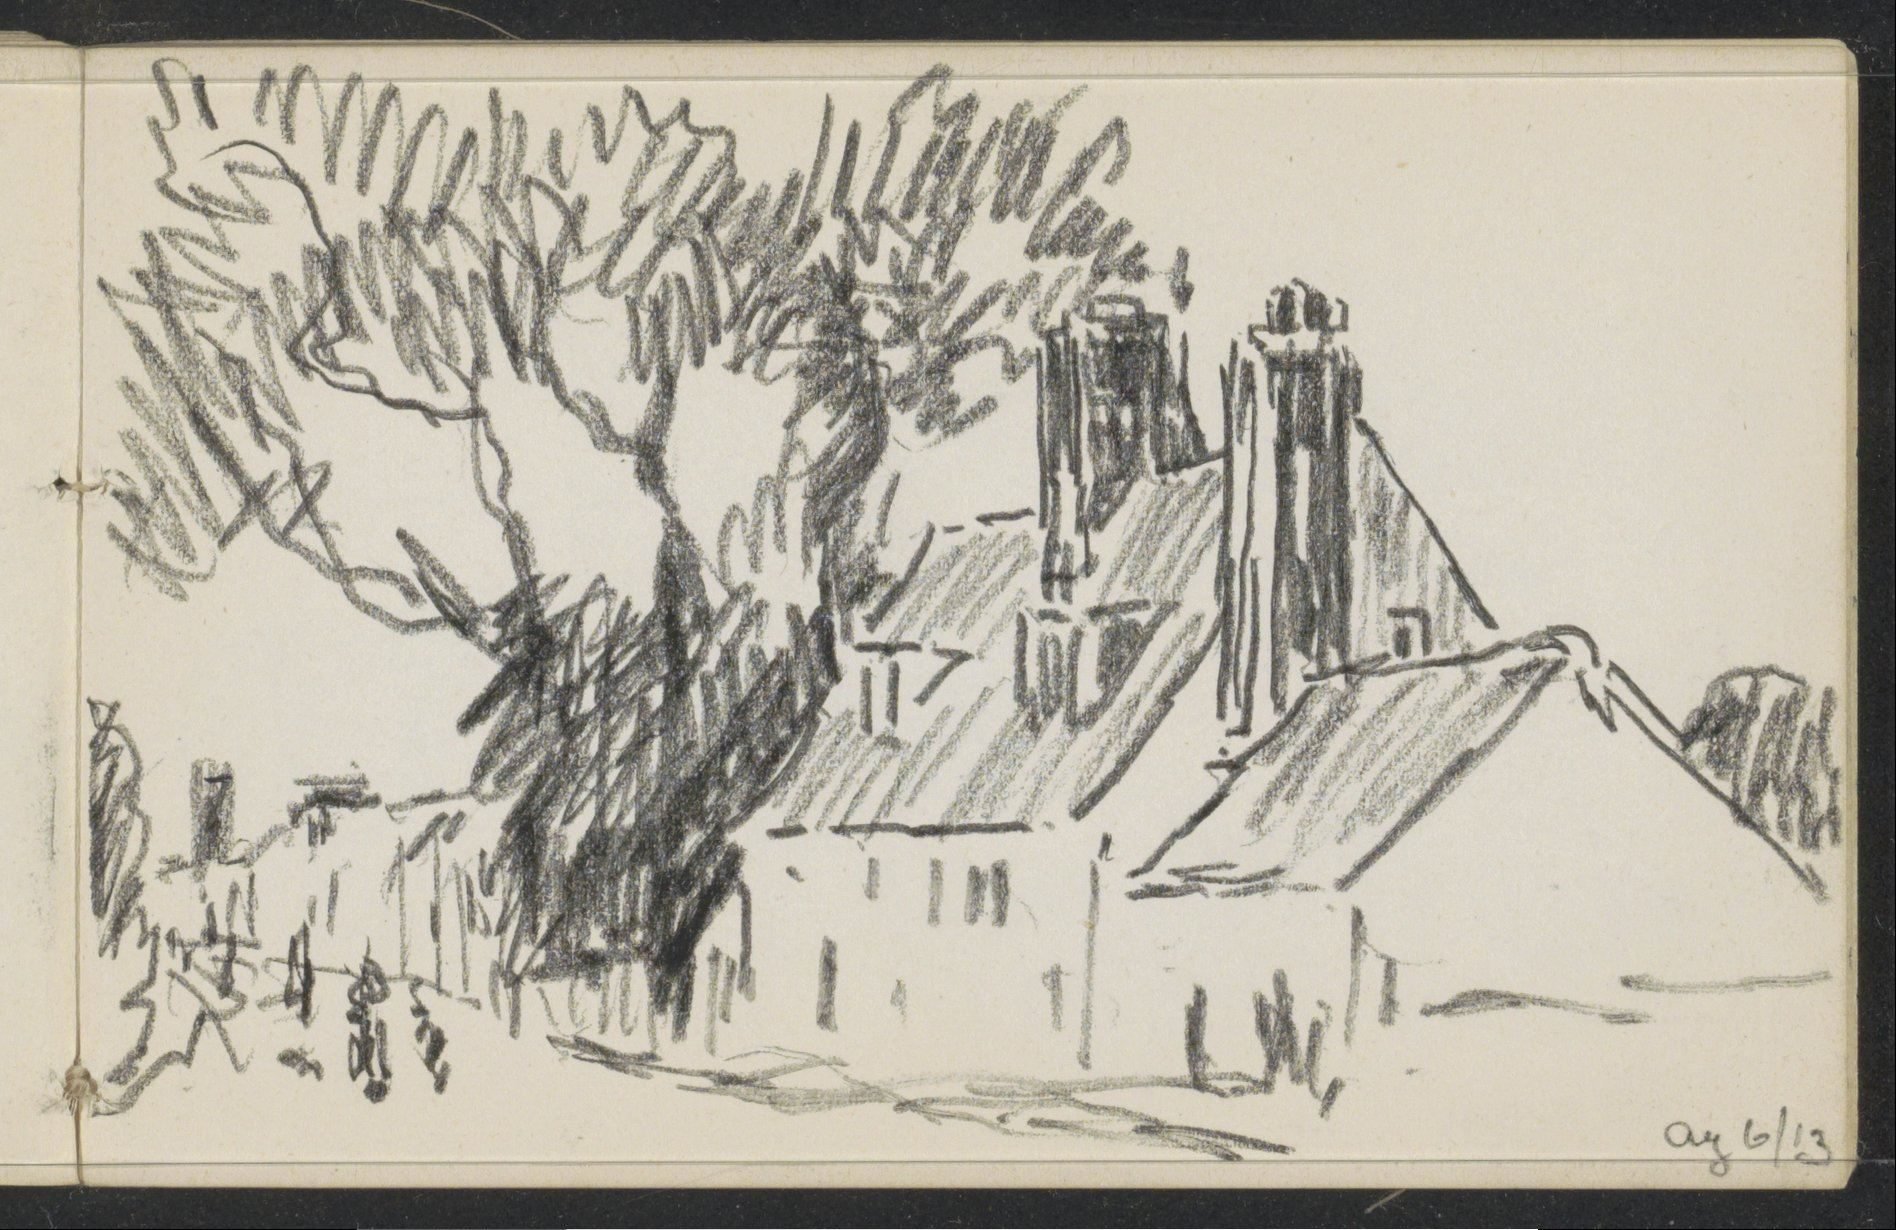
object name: sketchbook leaf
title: Dorpsstraat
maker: alexander shilling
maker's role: draughtsman, print maker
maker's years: 1859-1937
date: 1908-1913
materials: chalk, paper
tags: village street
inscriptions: date: ‘aug 6/13’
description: Blad 20 recto uit een schetsboek met 30 bladen.